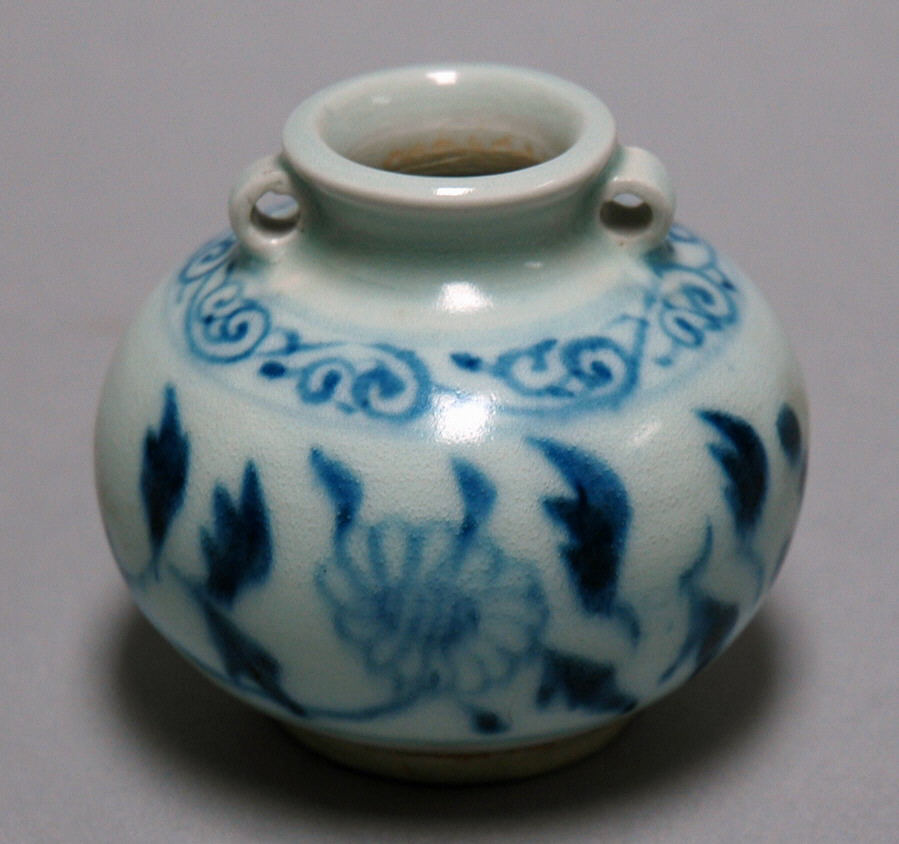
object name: jar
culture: chinese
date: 1301-1400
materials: porcelain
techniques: painting, underglaze